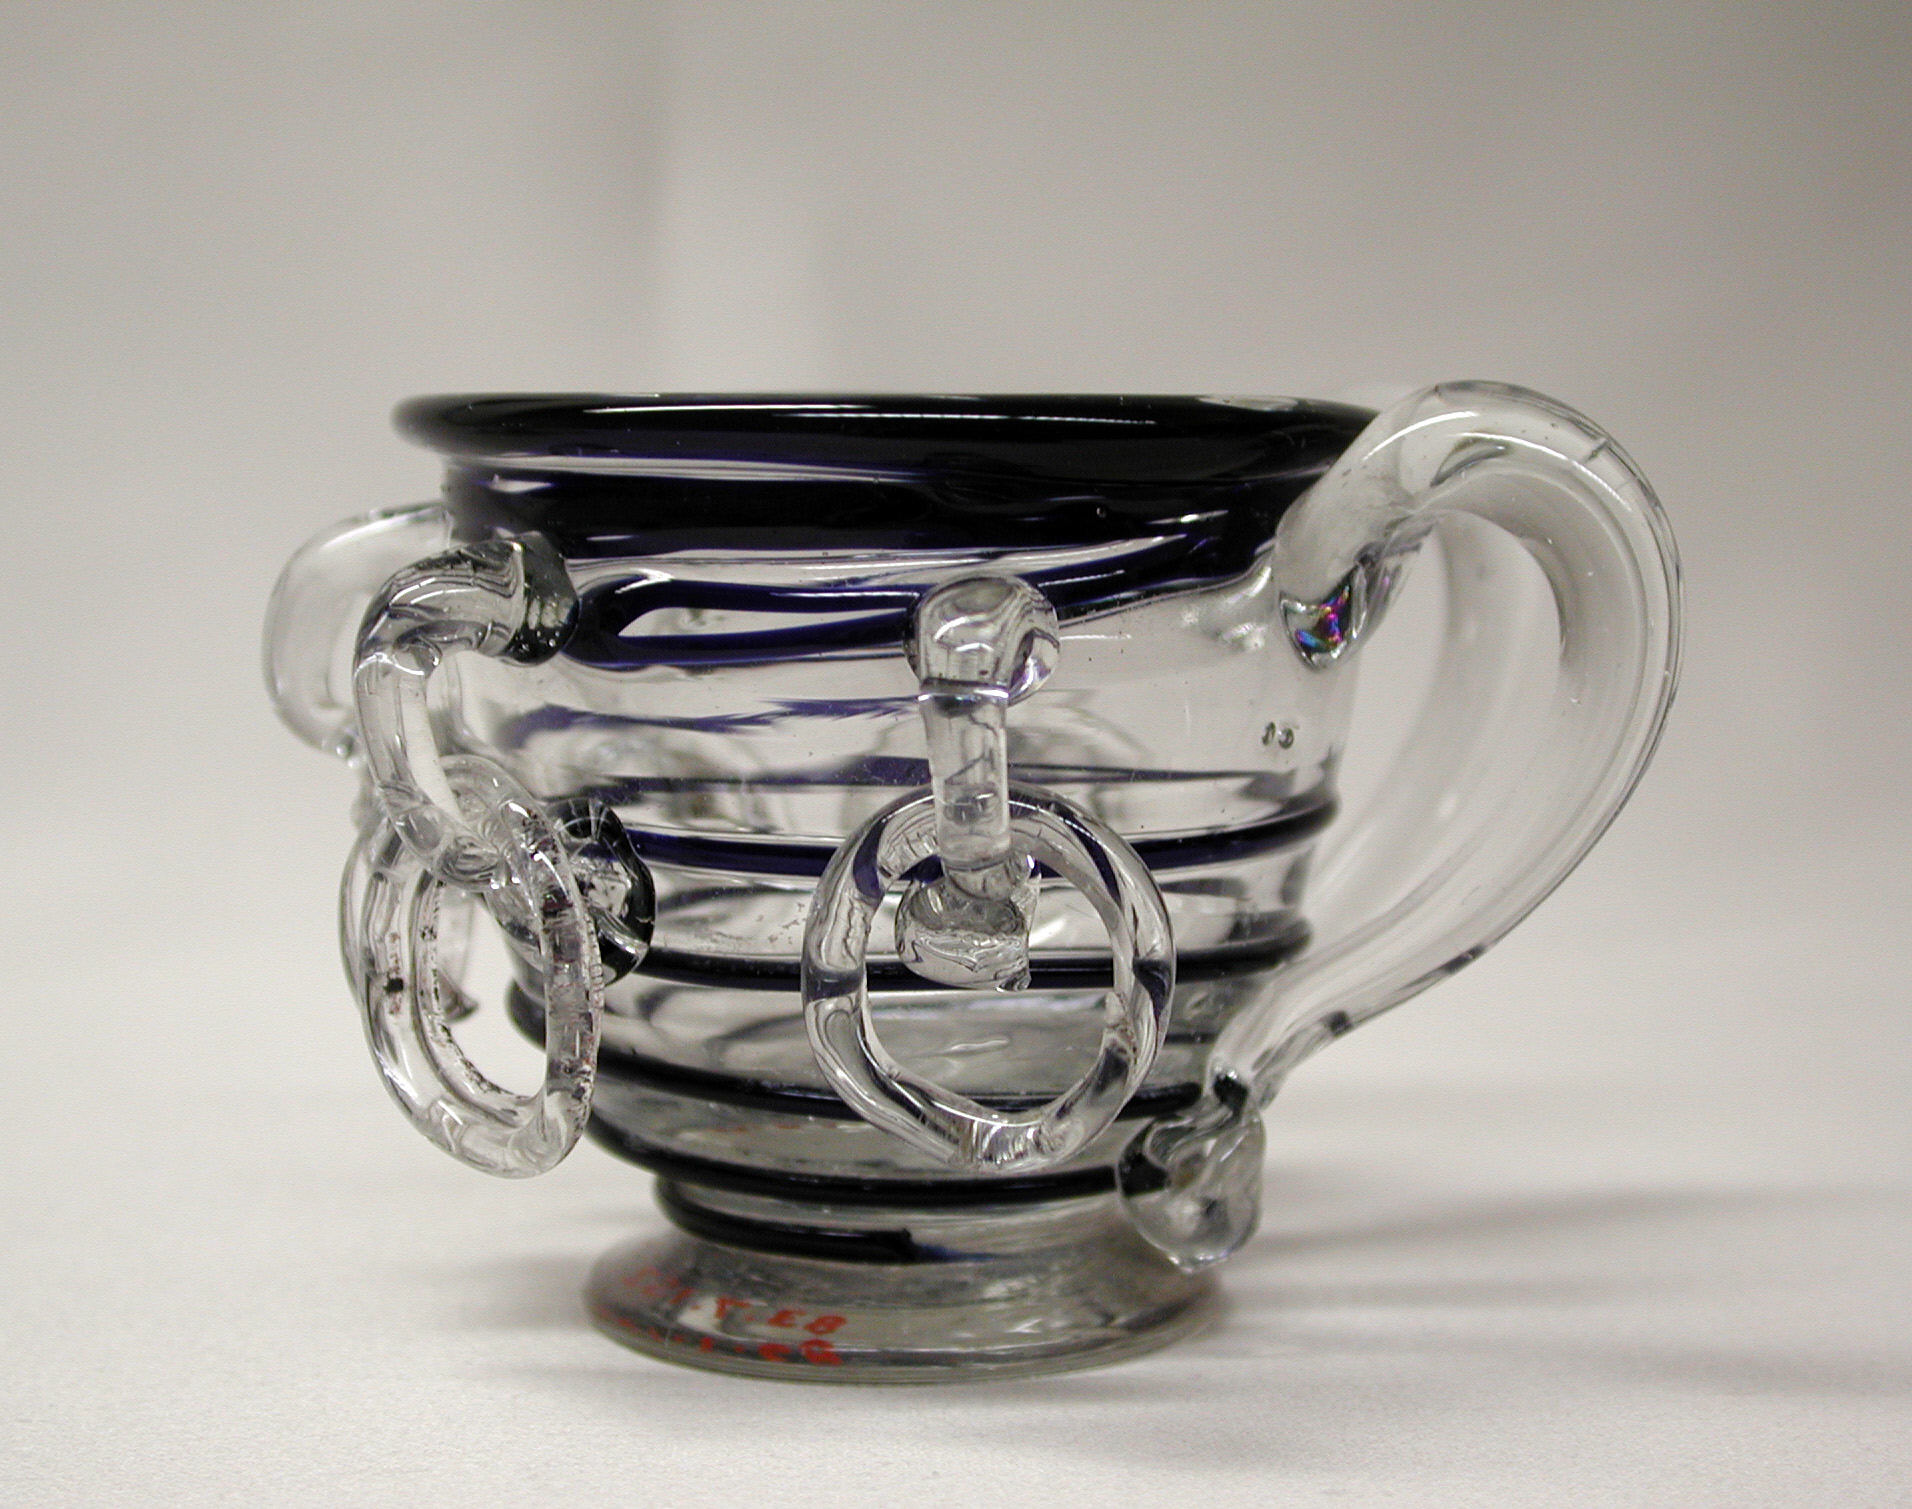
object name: cup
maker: manufacture royale de la margéride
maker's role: manufactory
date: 1785-1790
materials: glass